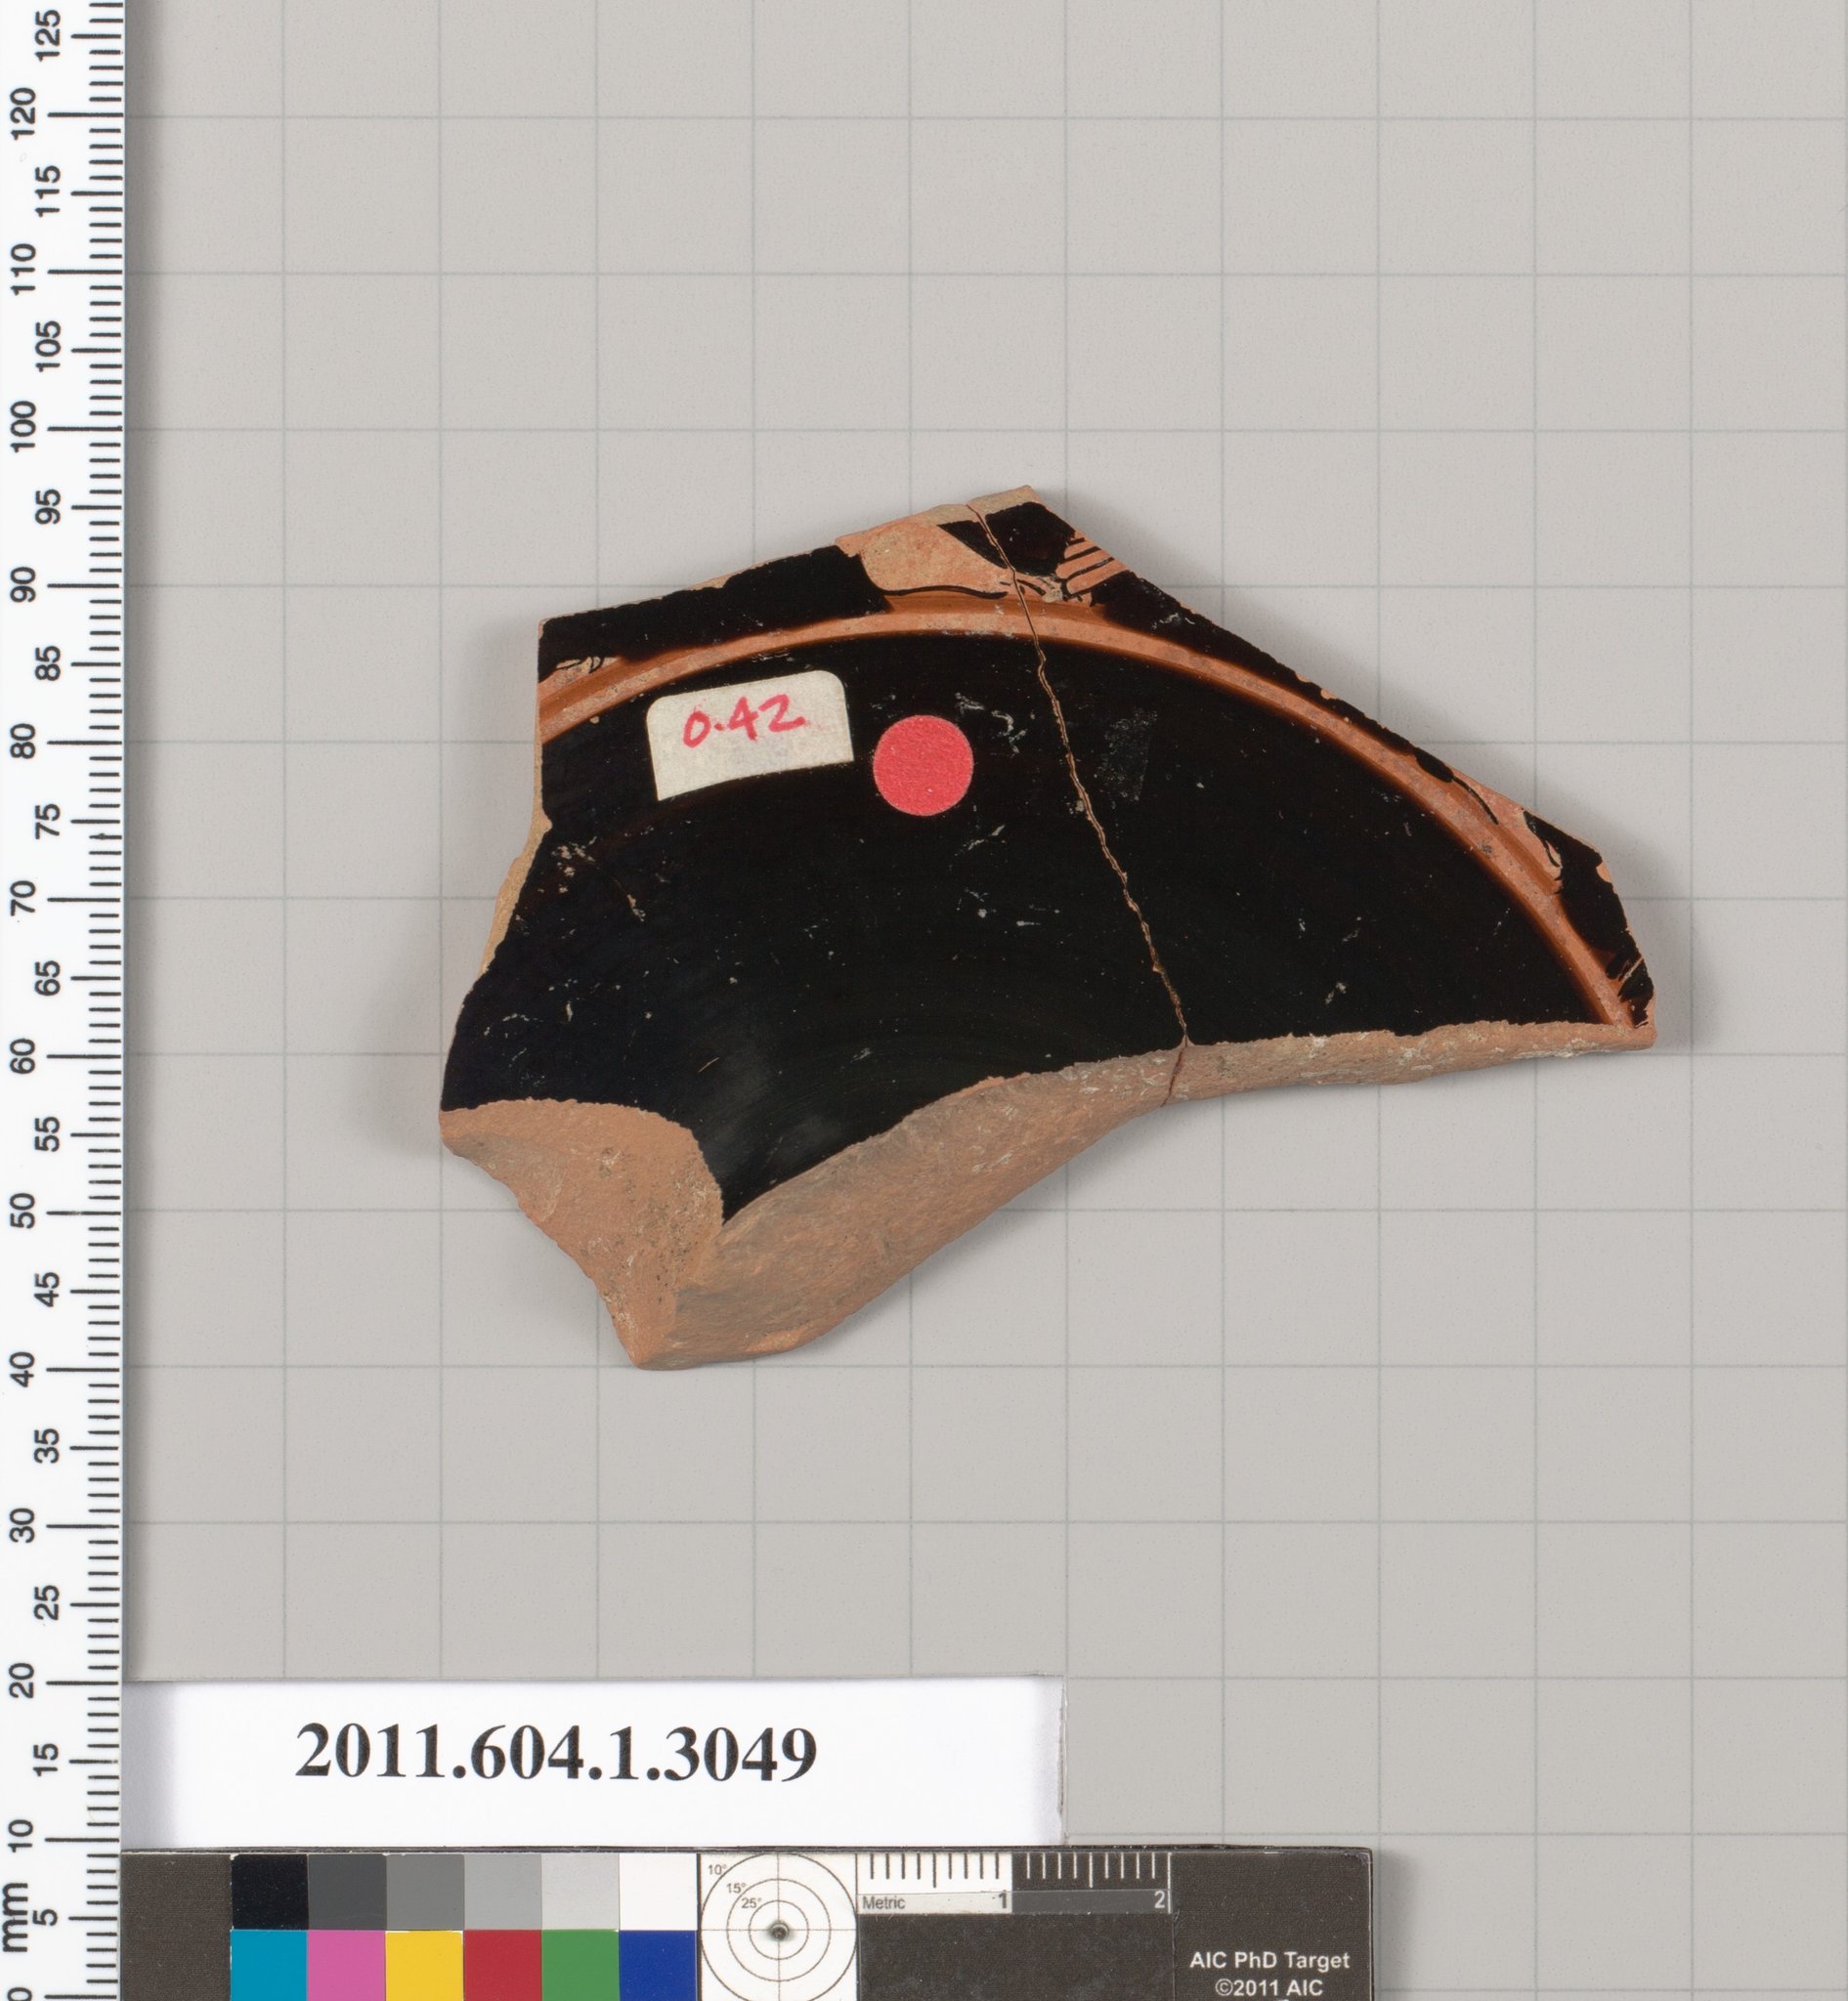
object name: kylix fragment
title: Terracotta fragment of a kylix (drinking cup)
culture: greek, attic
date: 500-480 BCE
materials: terracotta